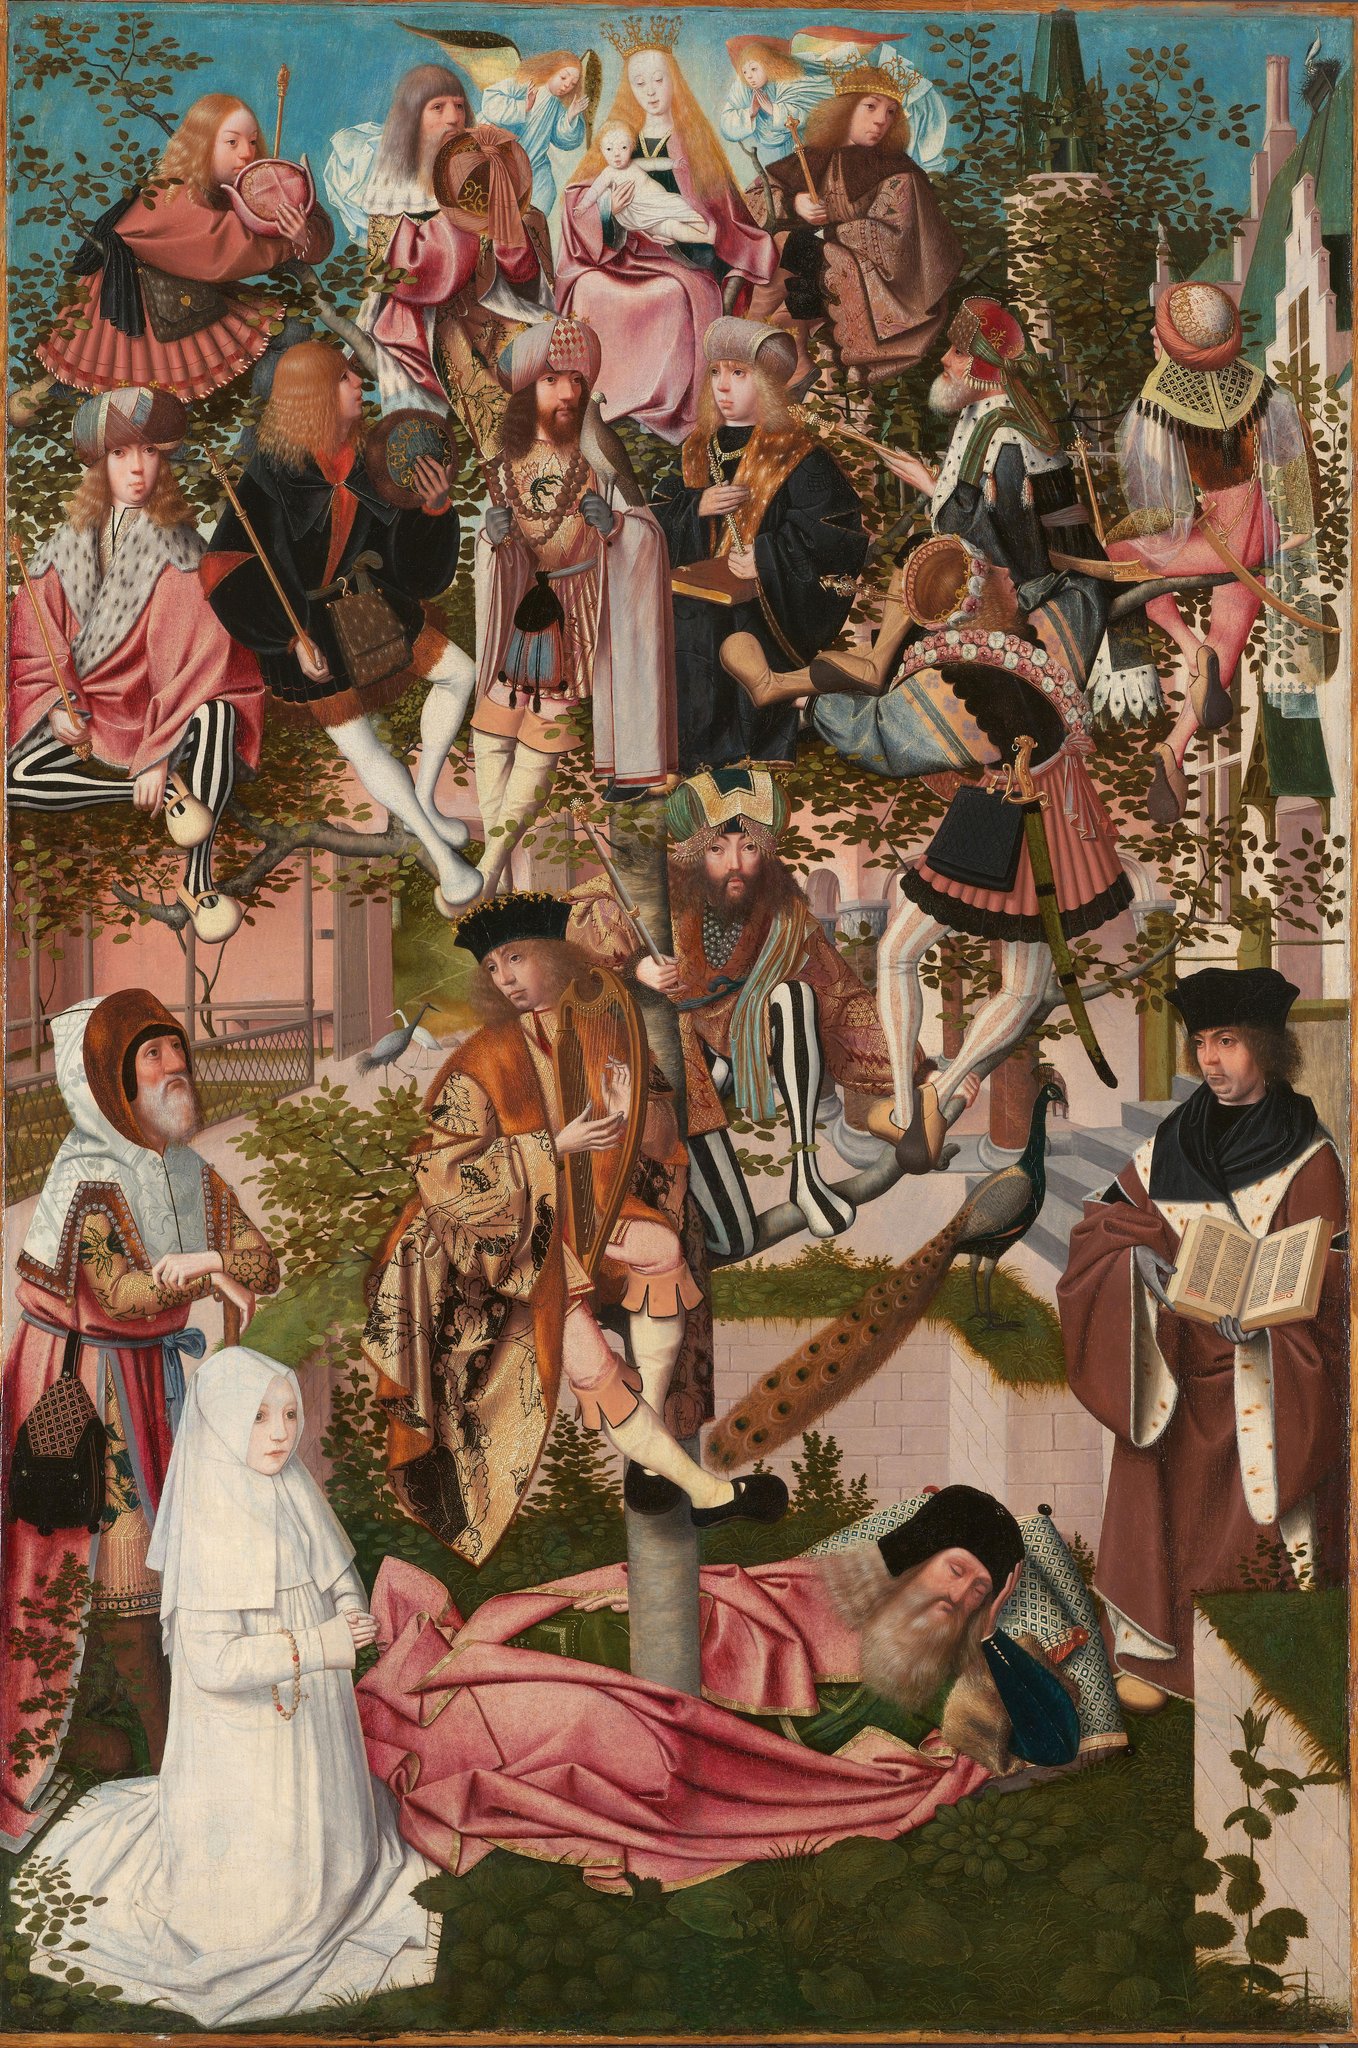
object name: painting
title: The Tree of Jesse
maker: geertgen tot sint jans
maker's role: painter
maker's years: 1455-1495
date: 1500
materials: oil, panel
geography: haarlem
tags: nun(s), fenced or walled garden; 'hortus conclusus', sceptre, staff (symbol of sovereignty), david as musician, usually playing the harp, aids for prayer, e.g. rosary, mary (standing) with the christ-child in front of her (free-standing); christ-child lying - ff - mary sitting or enthroned, tree of jesse: genealogical tree showing christ's ancestors, sprouting from jesse's loins (+ donor(s), supplicant(s), whether or not with patron saint(s))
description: Pictured here symbolically is Christ’s family tree. It grows out of the sleeping figure of Jesse, forefather of a line of kings that included, according to tradition, Salomon, David and Jesus.The branches are filled with the kings of Israel, among them King David with his harp. At top, the Virgin is enthroned with the Christ Child on her lap.